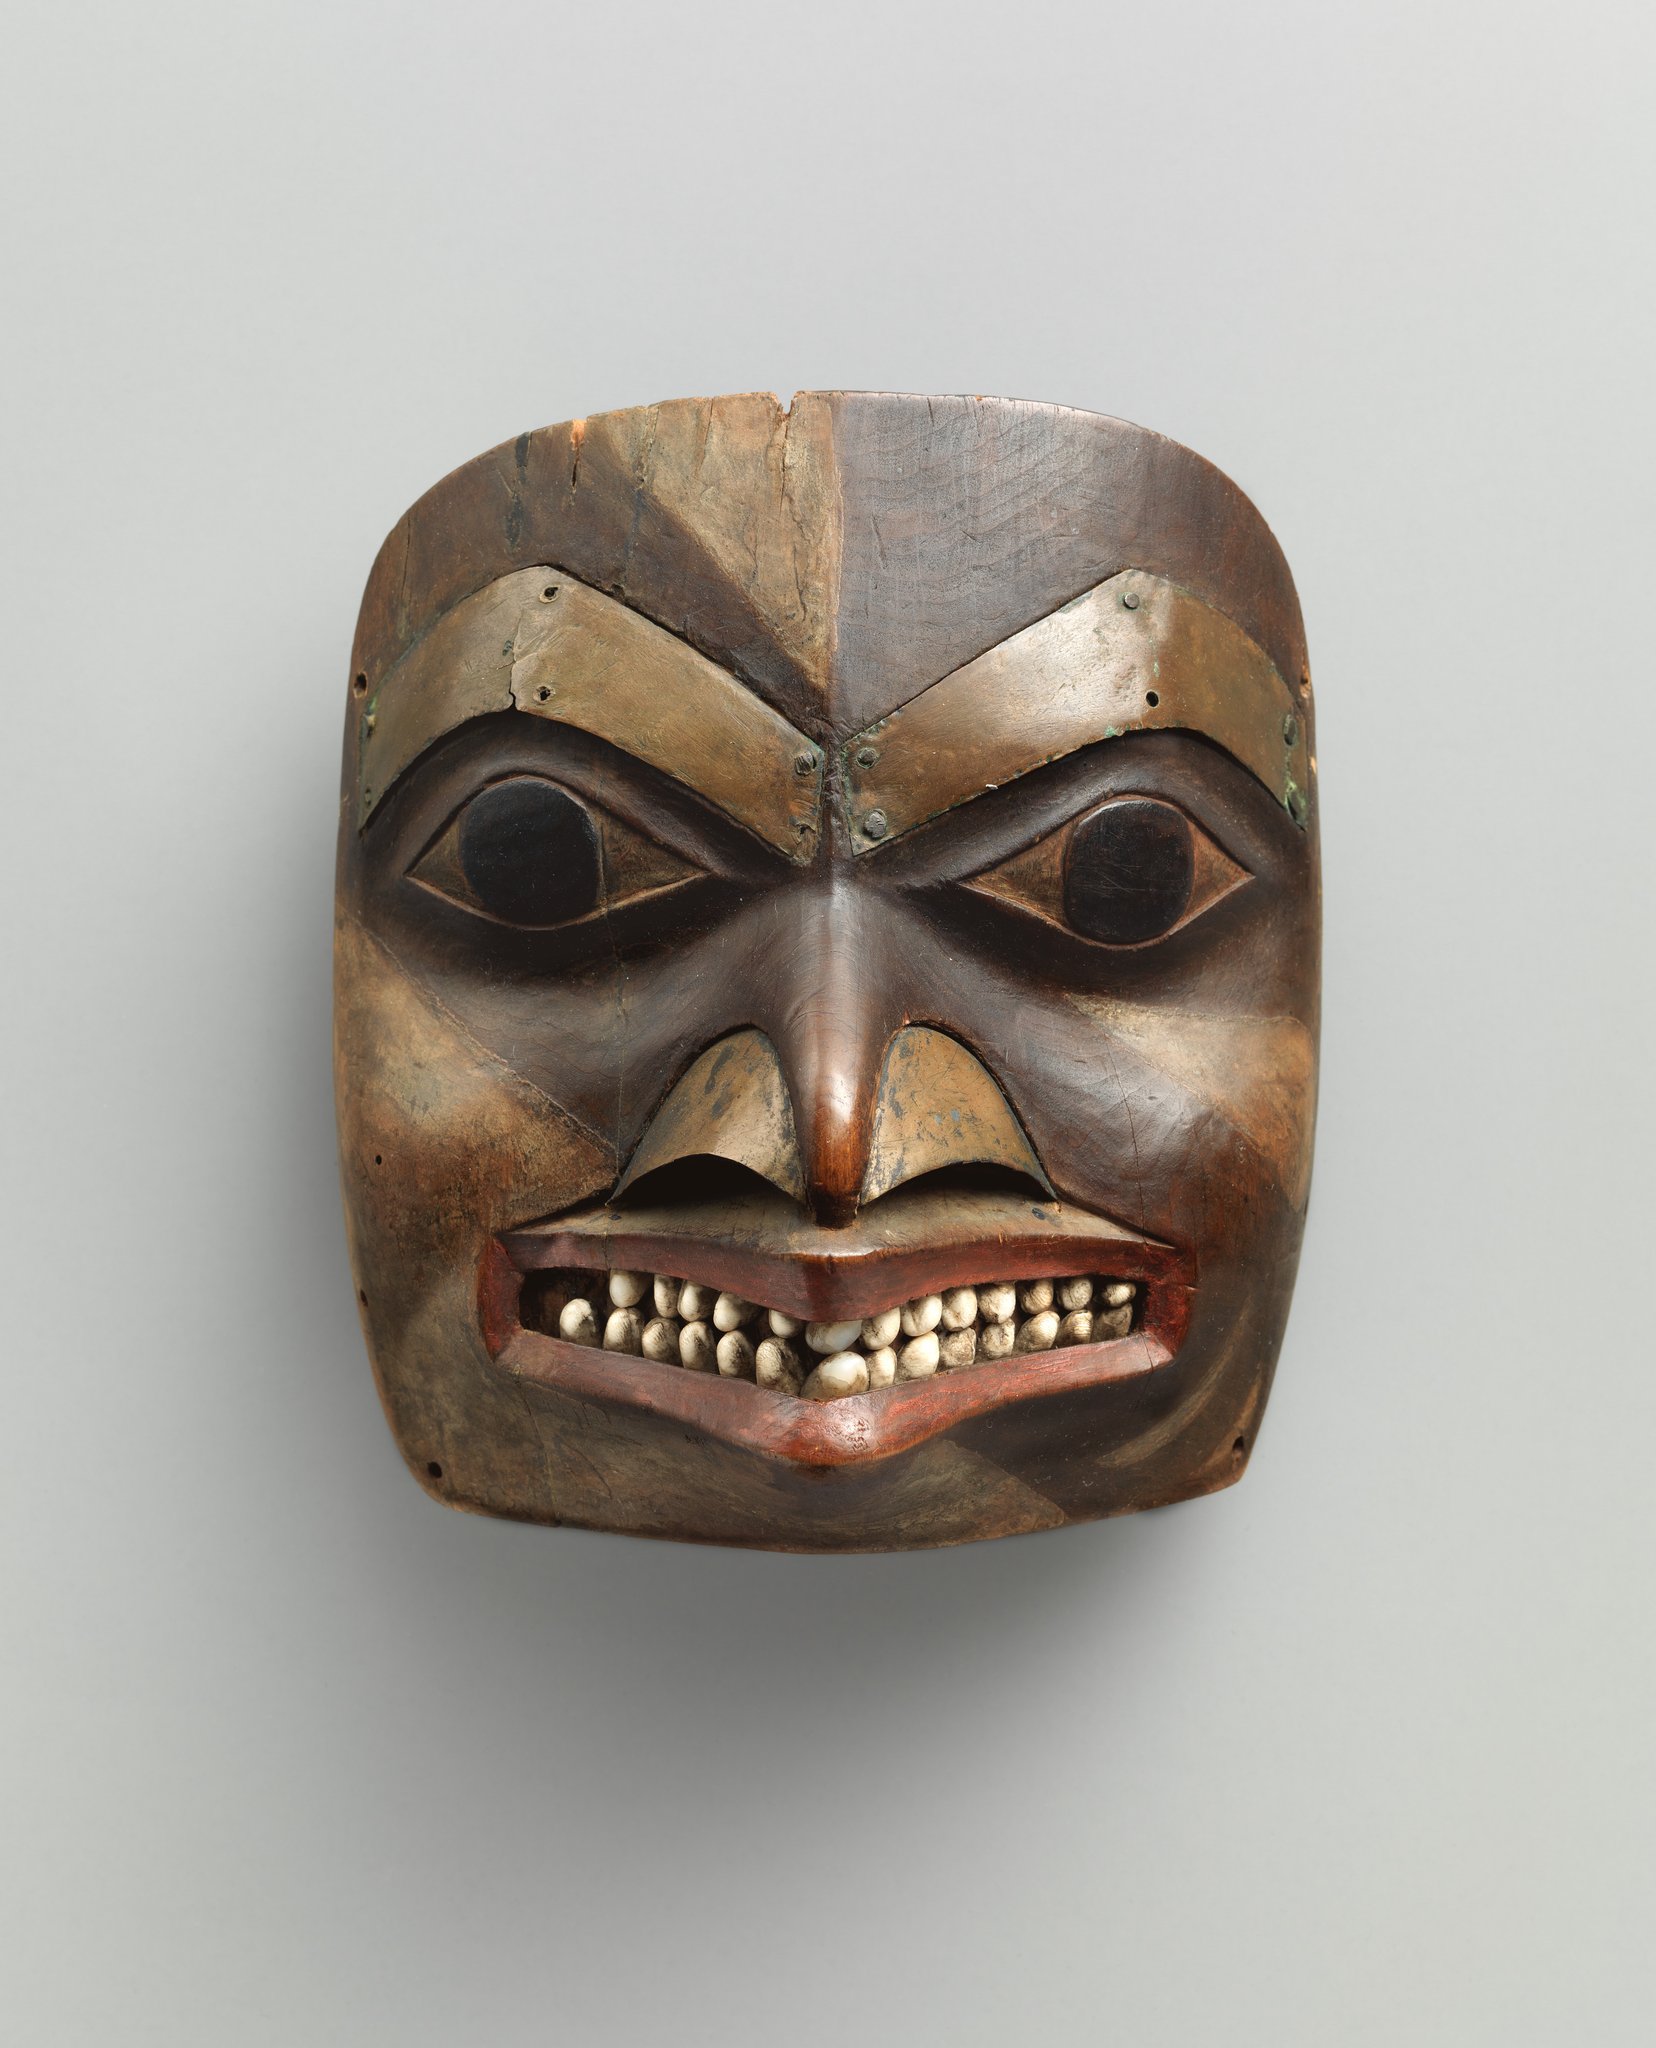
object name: maskette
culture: tlingit or tsimshian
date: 1780-1830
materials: copper, pigment, shell, wood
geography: united states